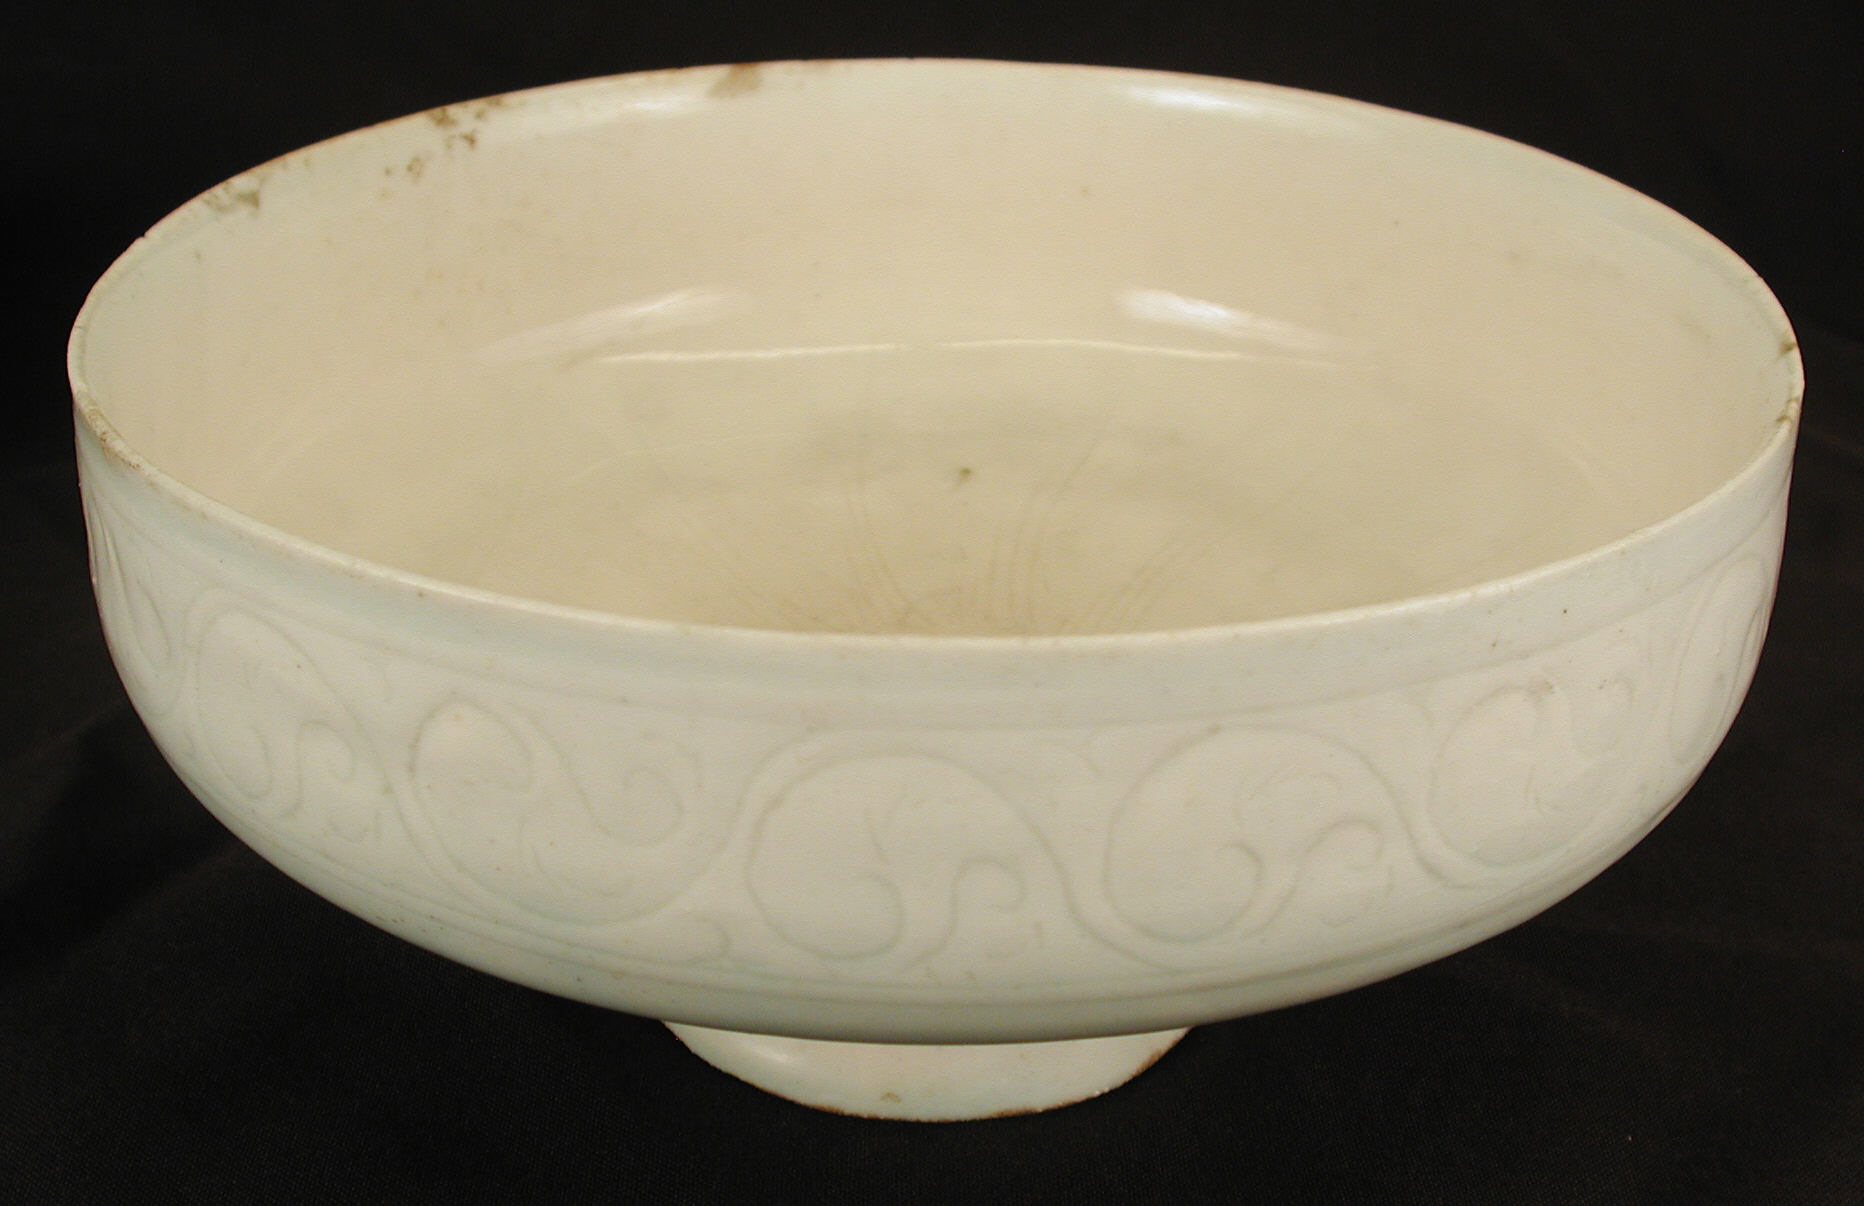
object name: bowl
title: White Bowl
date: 1101-1200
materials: glaze, stonepaste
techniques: incising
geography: iran